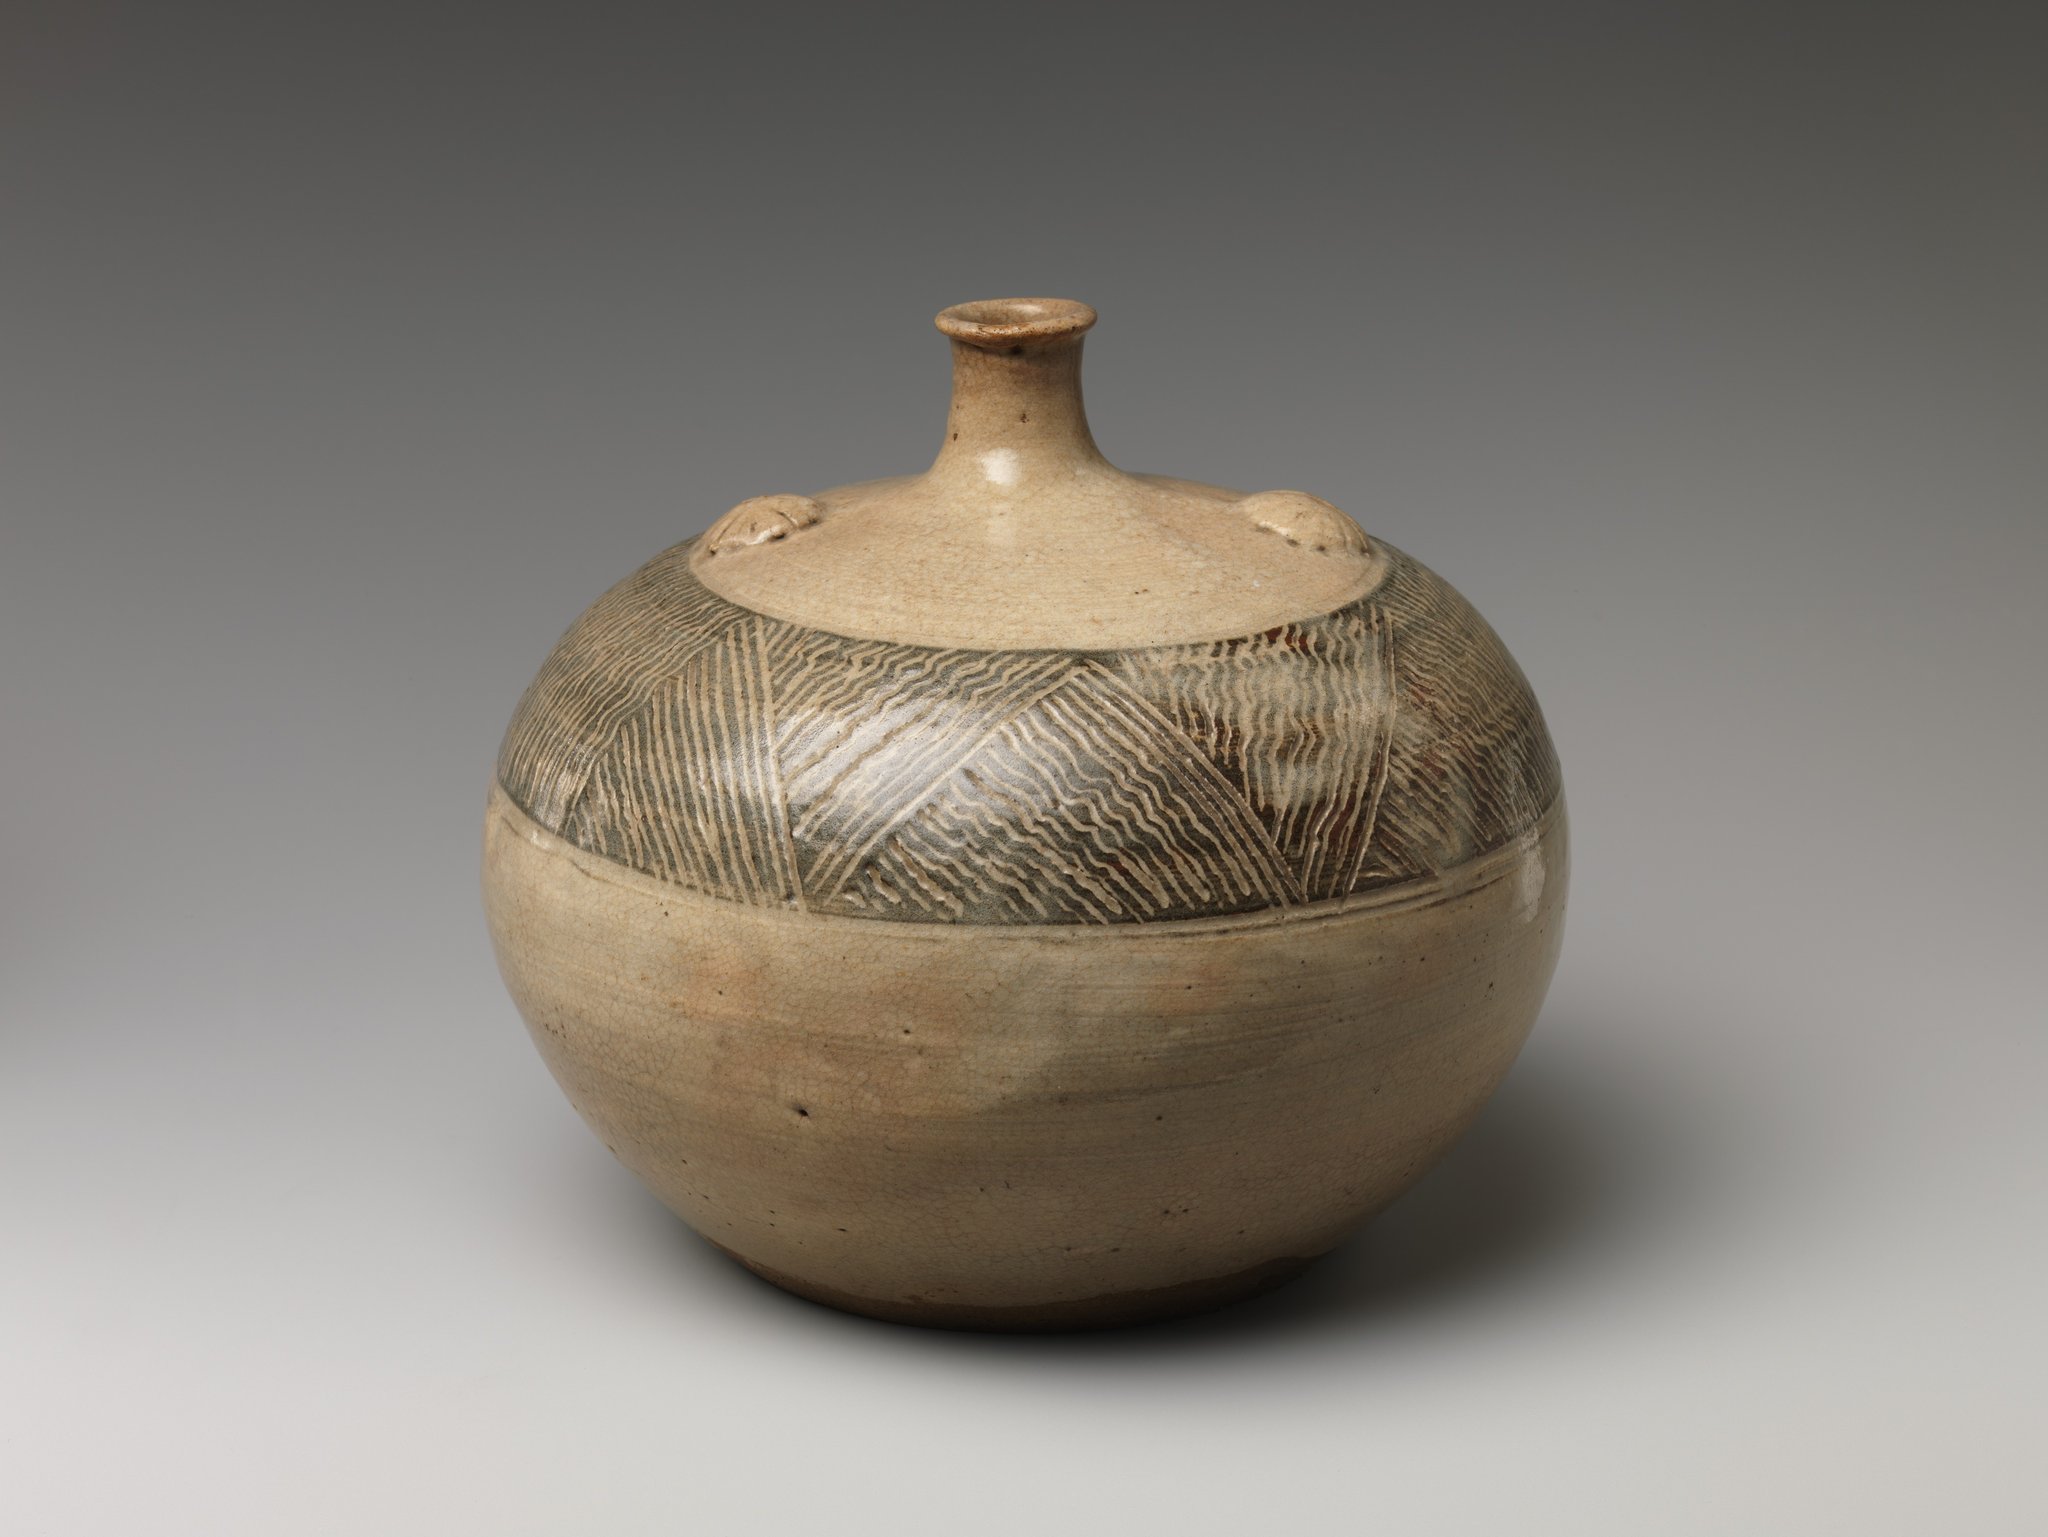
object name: oil bottle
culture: japanese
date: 1801-1900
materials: clay, glaze